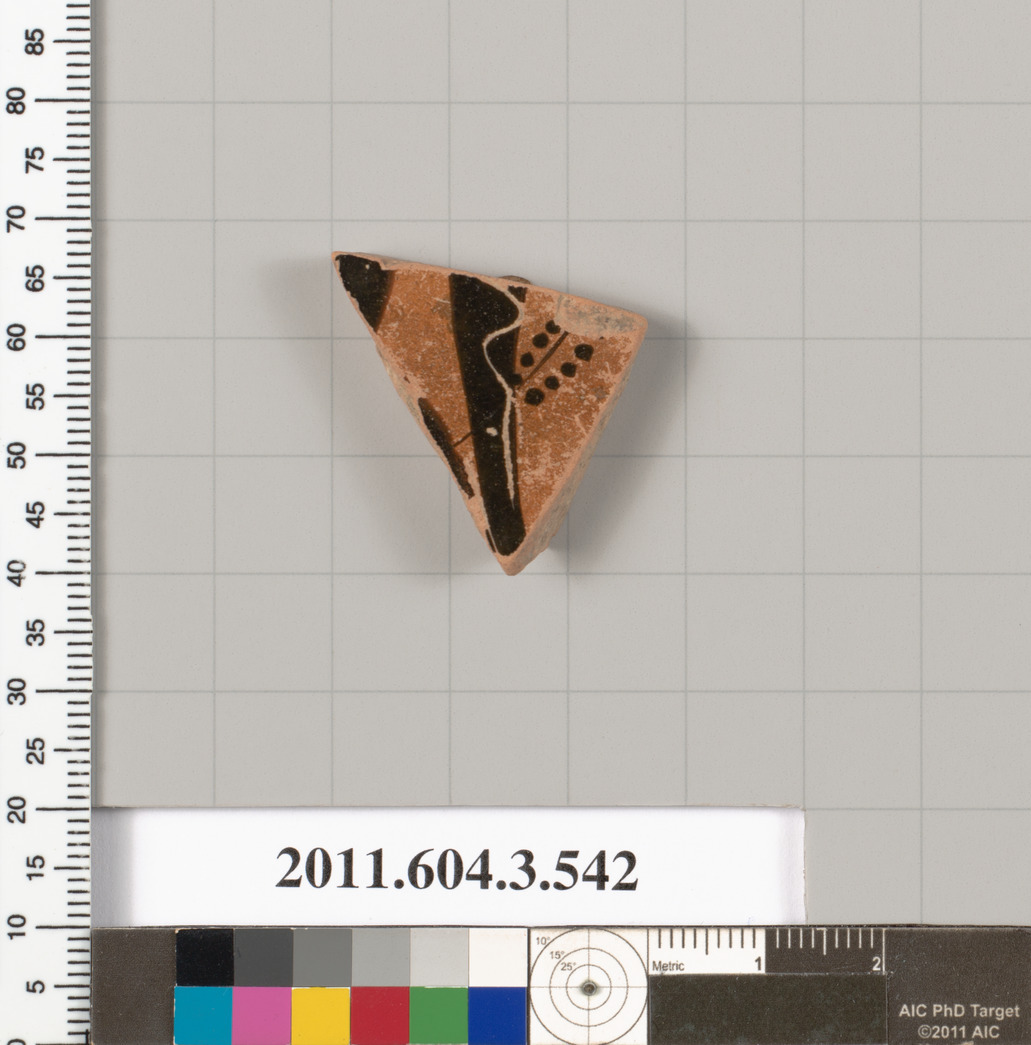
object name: column krater fragment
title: Terracotta fragment of a column-krater (bowl for mixing wine and water)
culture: greek, attic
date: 534-468 BCE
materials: terracotta